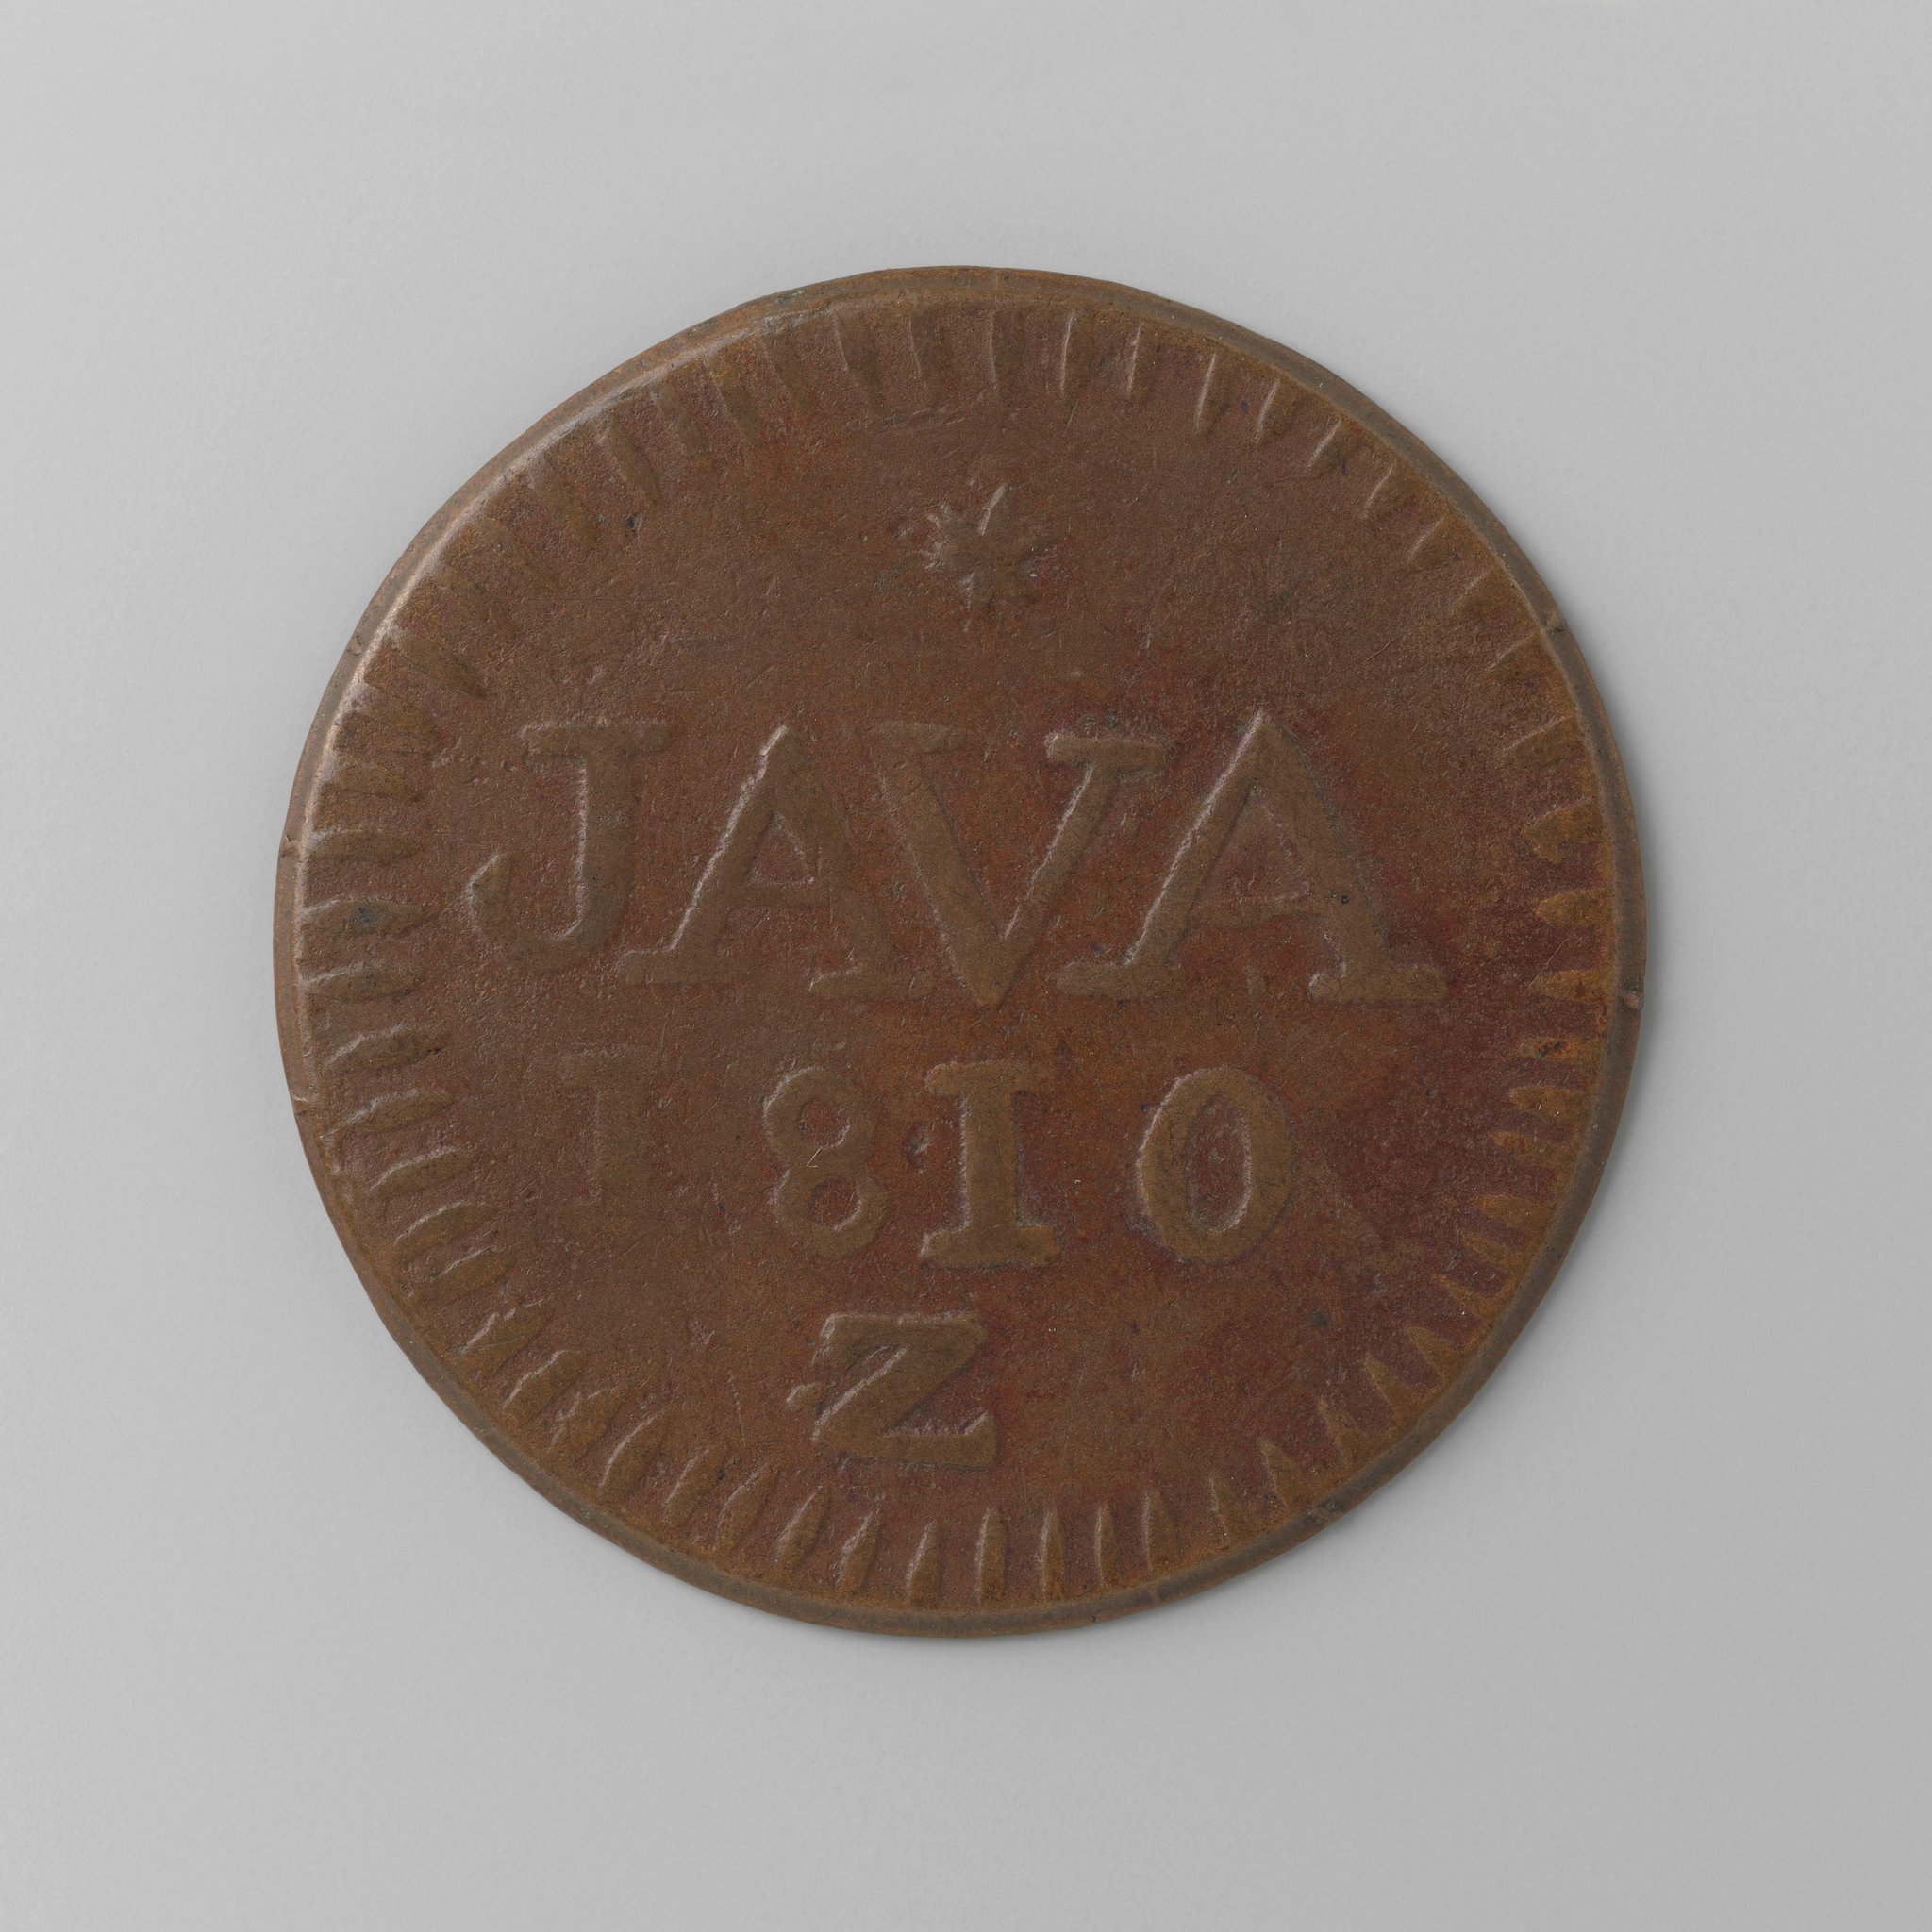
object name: coin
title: Stuiver voor Nederlands Indië uit Java,1810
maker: louis napoleon (king of holland)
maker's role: koning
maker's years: 1778-1846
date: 1810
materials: copper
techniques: striking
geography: surabaya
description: Koperen munt. Voorzijde: tussen waarde/aanduiding I St ineen gestrengelde initialen L en N van Lodewijk Napoleon. Daarboven muntteken. Keerzijde: eenregelig opschrift, waaronder jaartal. Boven opschrift muntteken en onder jaartal muntmeesterteken Z [=muntmeester Zwekkert].